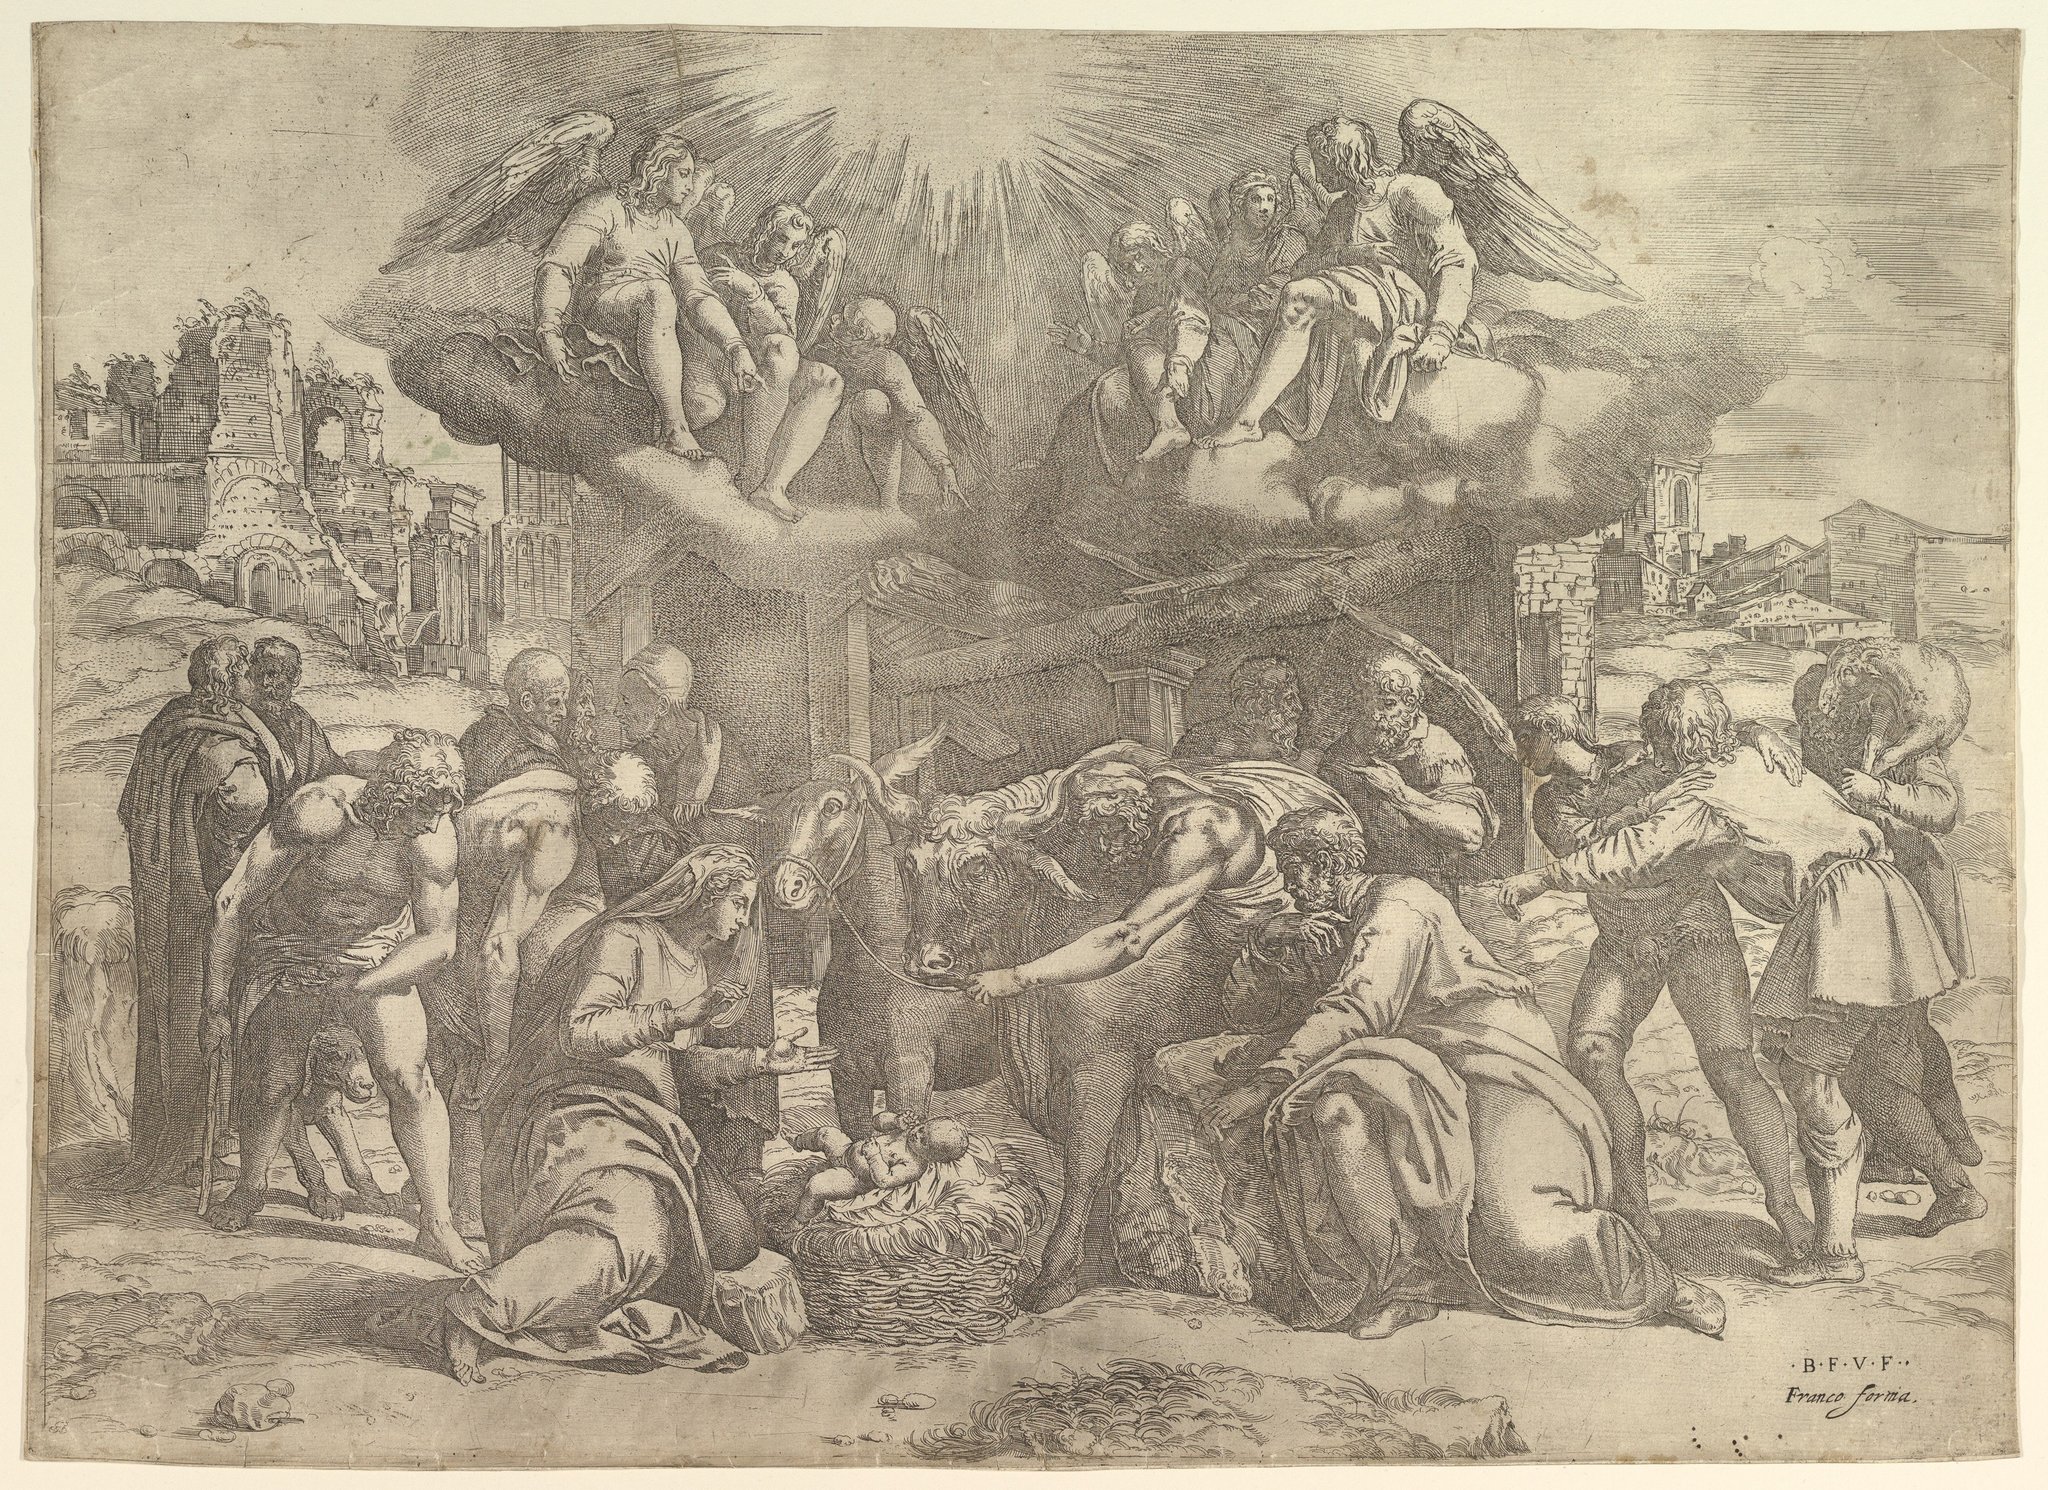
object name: print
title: The Adoration of the Shepherds with angels overhead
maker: battista franco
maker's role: artist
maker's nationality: italian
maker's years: 1510-1561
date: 1530-1561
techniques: engraving, etching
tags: animals,angels,virgin mary,jesus,adoration of the shepherds